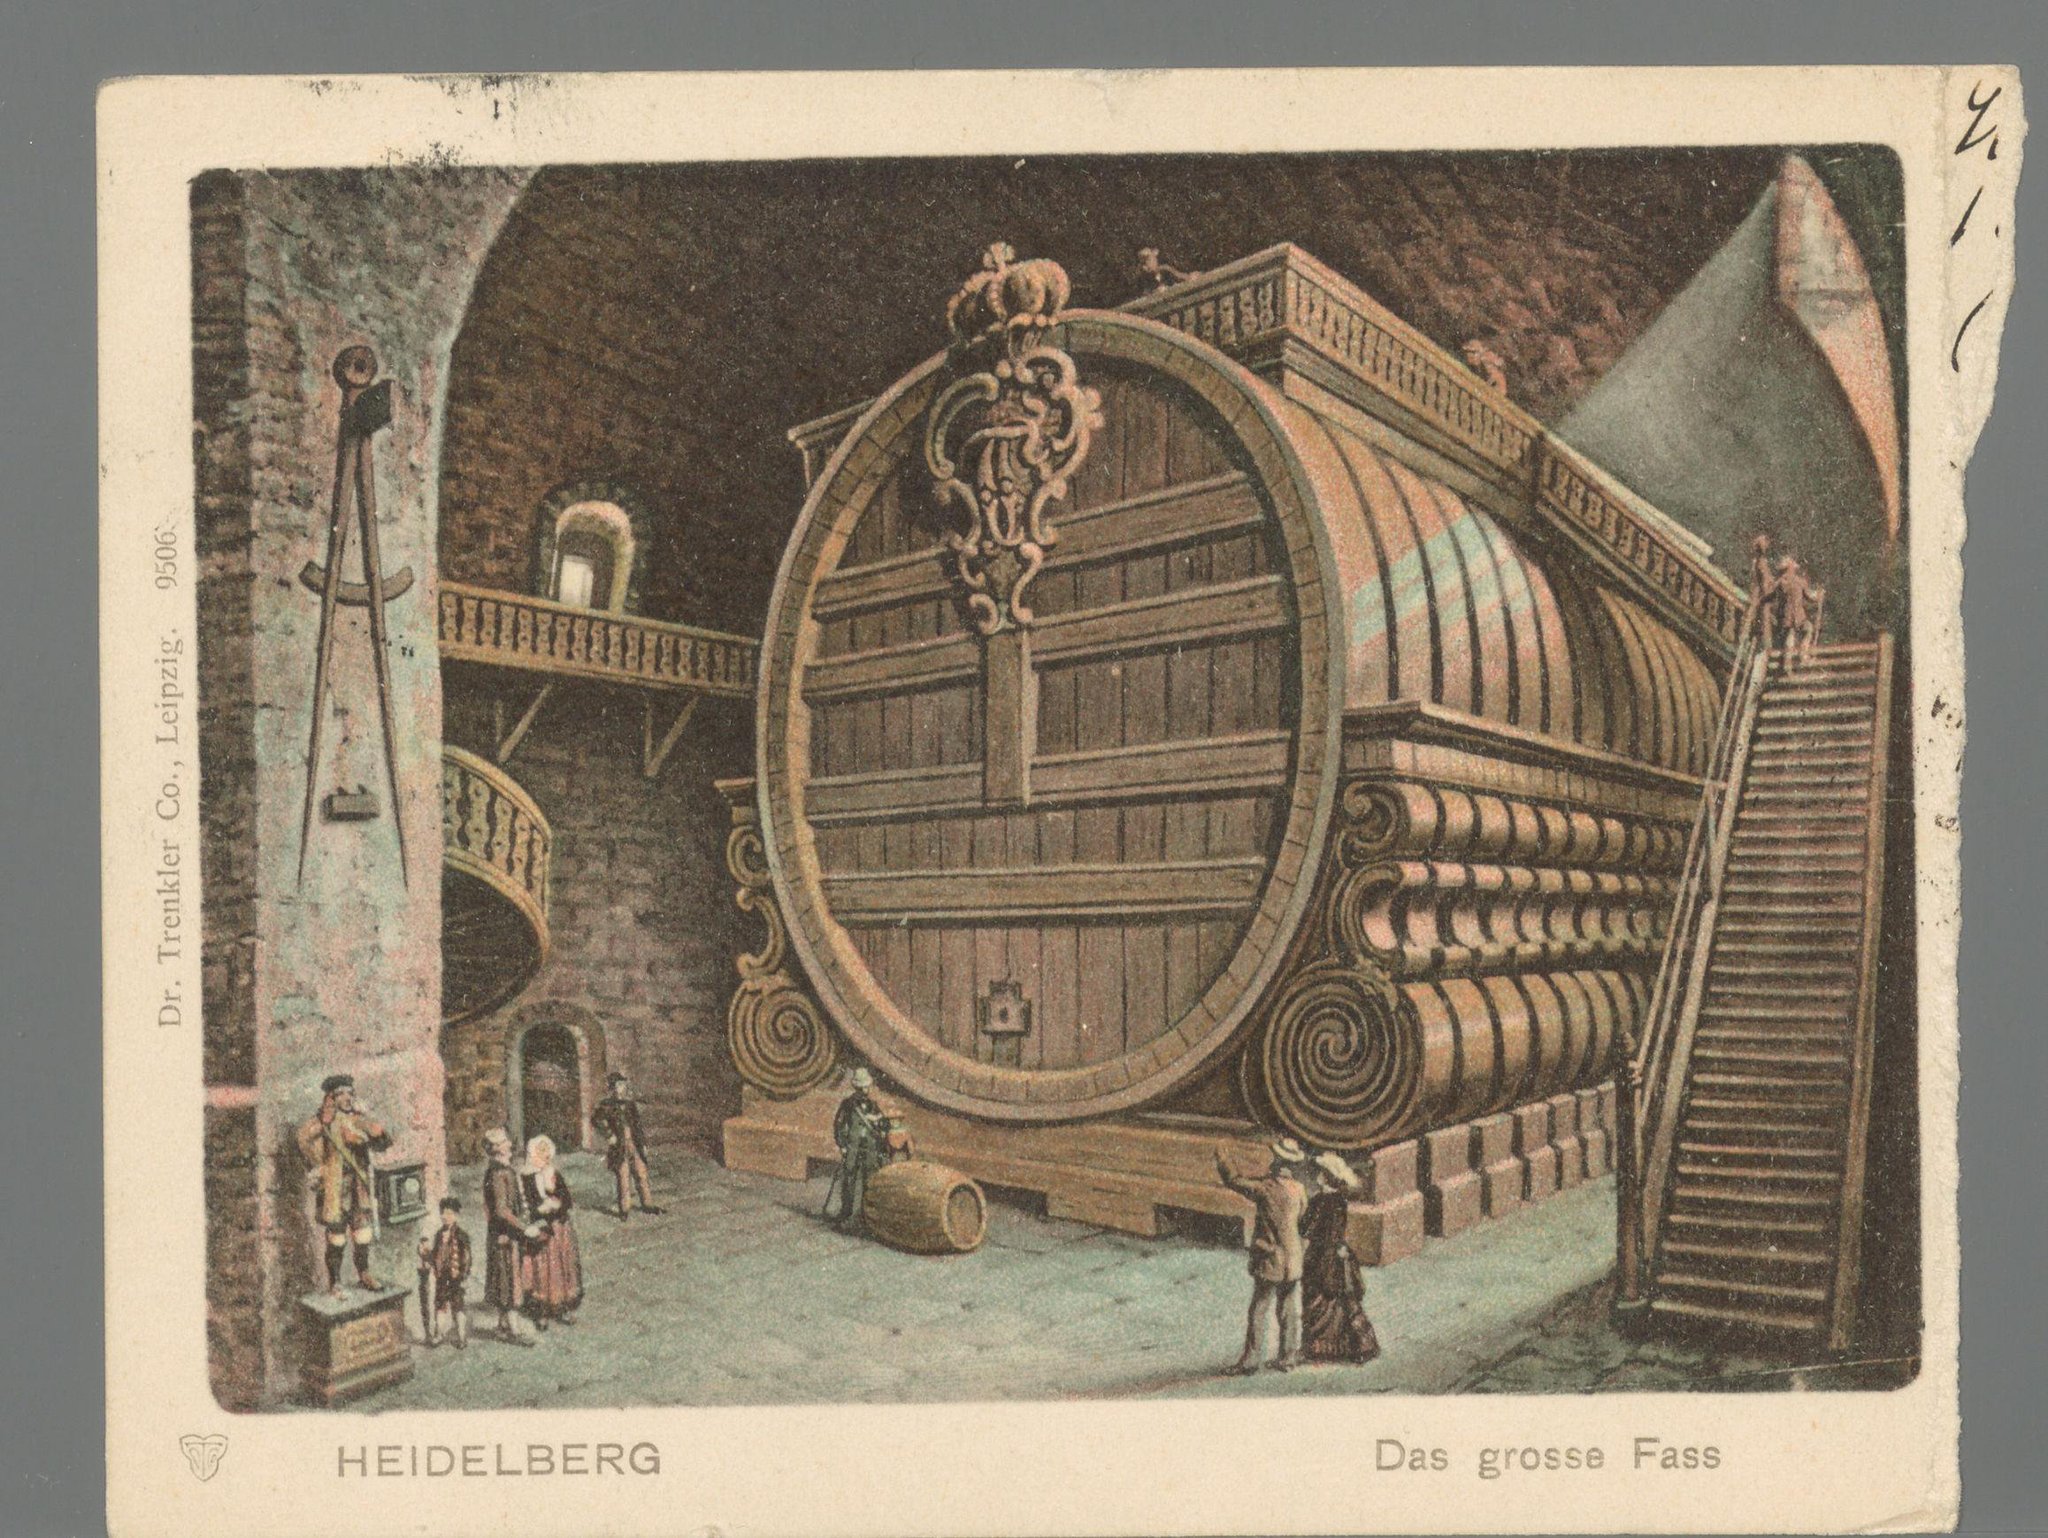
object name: photomechanical print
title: Heidelberg. Das grosse Fass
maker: Anonymous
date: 1894-1905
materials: cardboard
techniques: photograph, lithograph, writing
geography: leipzig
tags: wooden container: barrel, cask, bucket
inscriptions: postage stamp